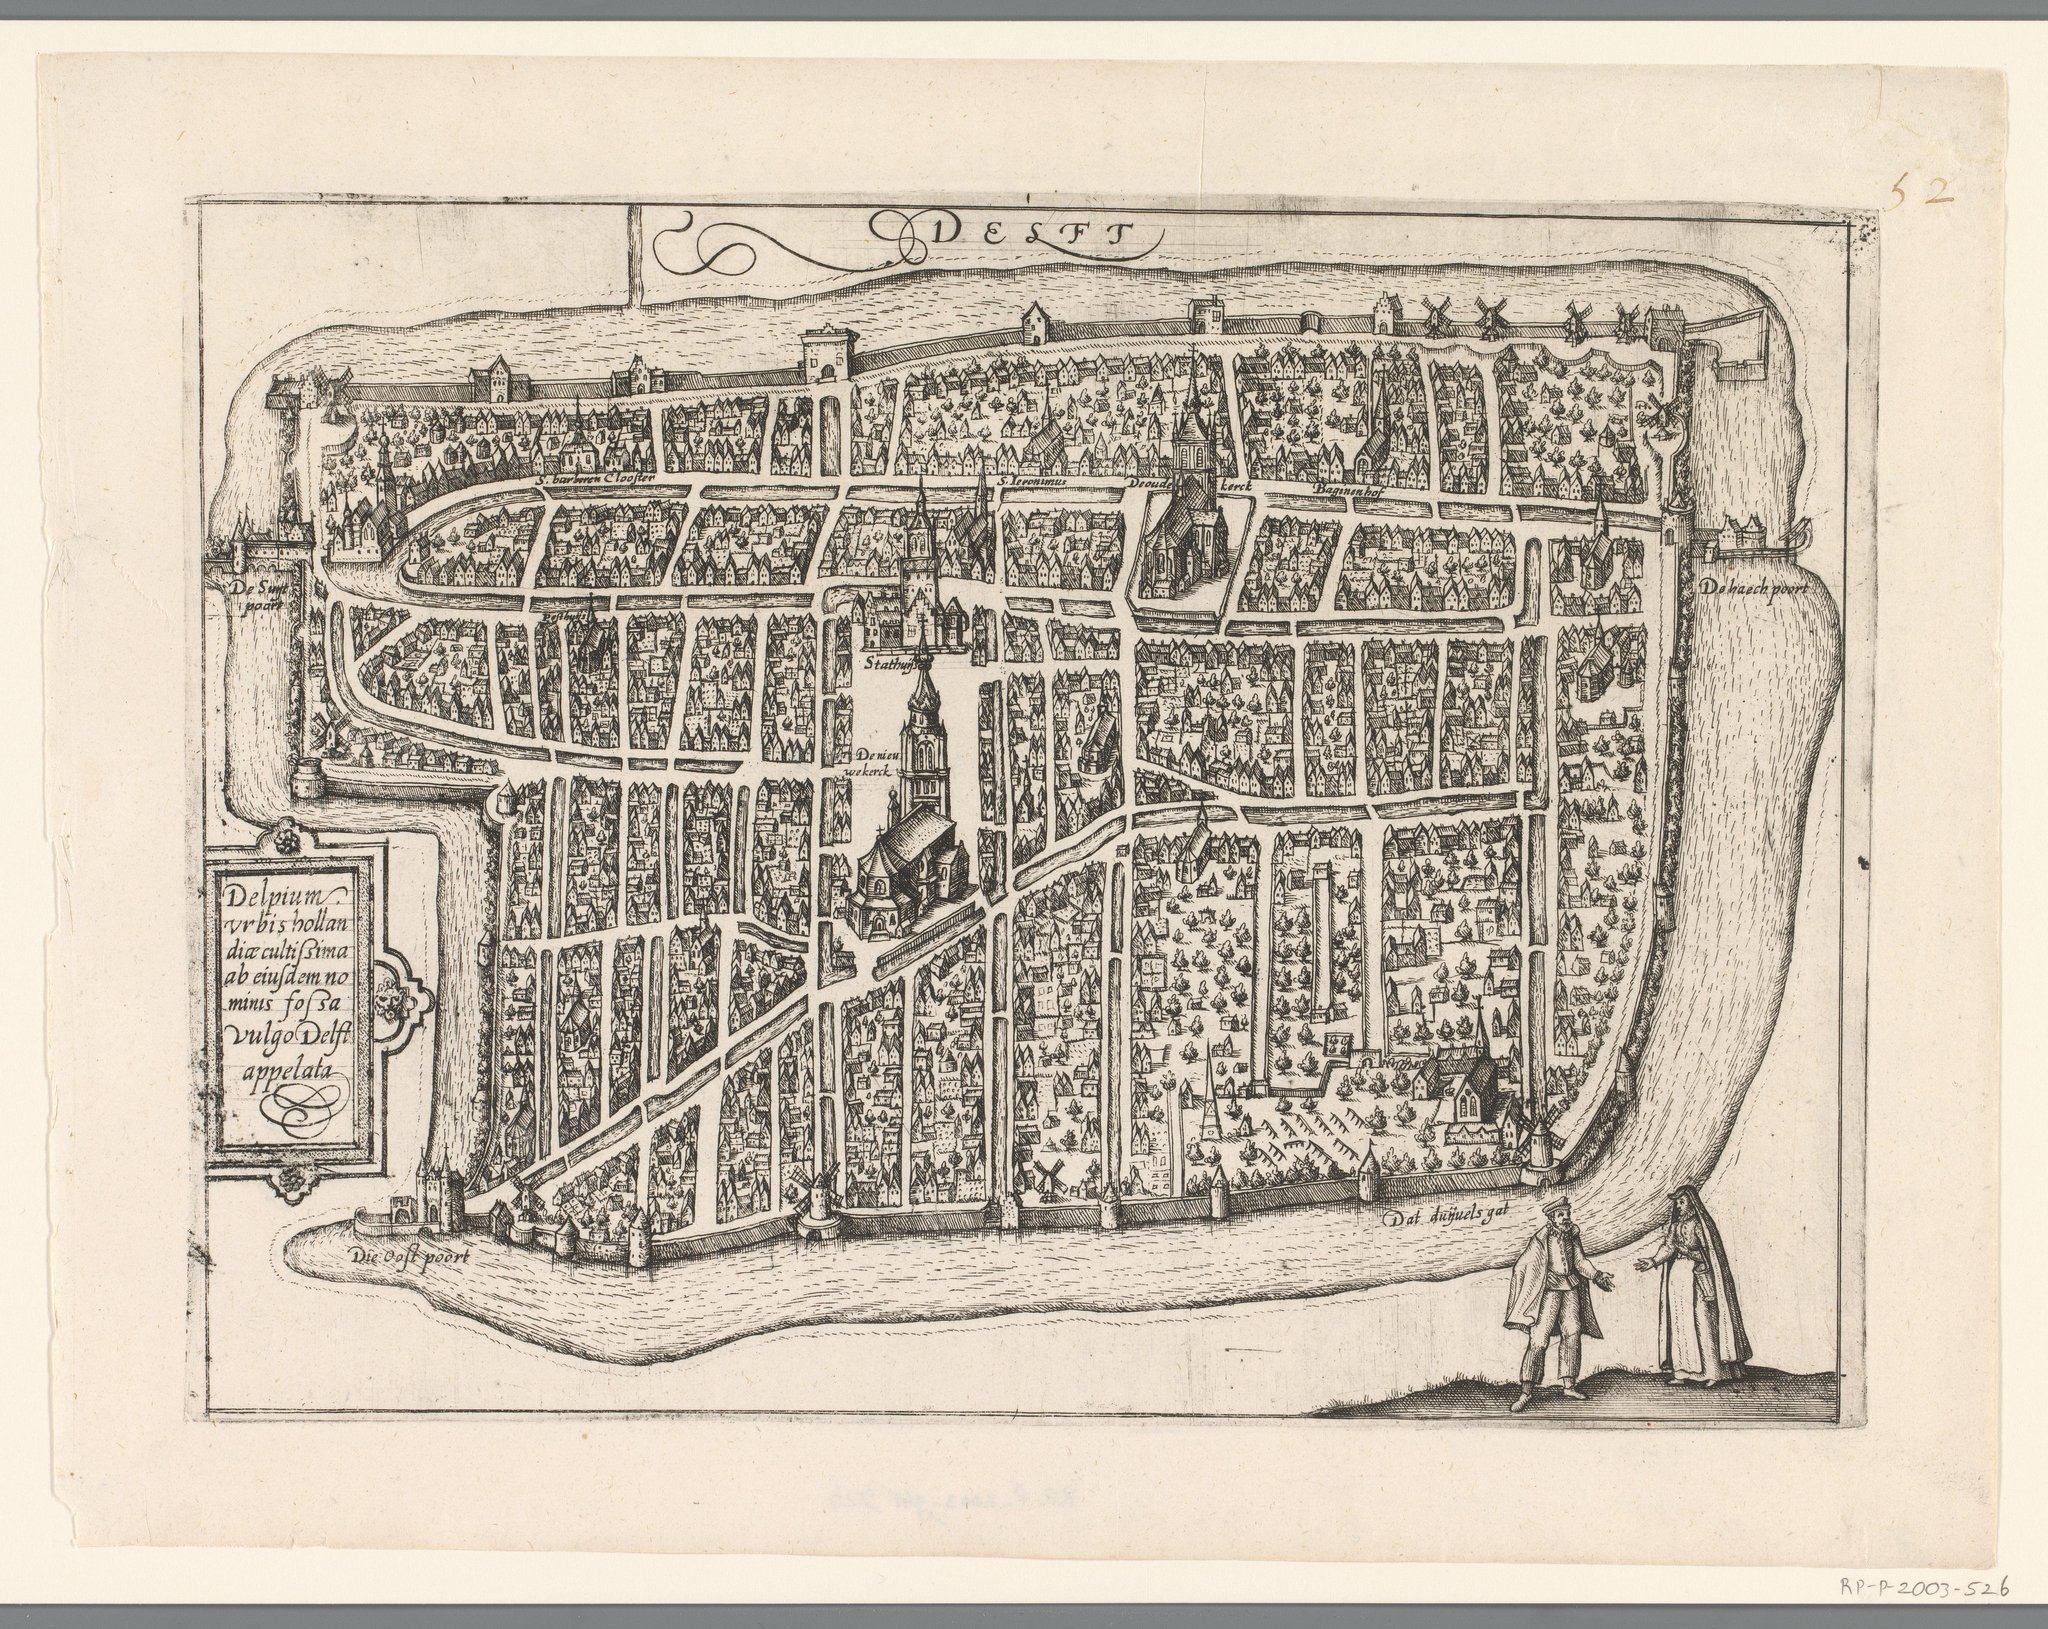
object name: area plan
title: Plattegrond van Delft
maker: Anonymous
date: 1607-1609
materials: paper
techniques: etching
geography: southern netherlands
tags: maps of cities, delft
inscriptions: number: ‘52’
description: Plattegrond van de stad Delft. Bovenaan de titel, linksonder een cartouche met de Latijnse titel. Rechtsonder een man en een vrouw. Onderdeel van de verzameling kaarten genomen uit een latere editie van: Descrittione di tutti i Paesi Bassi van Lodovico Guicciardini.